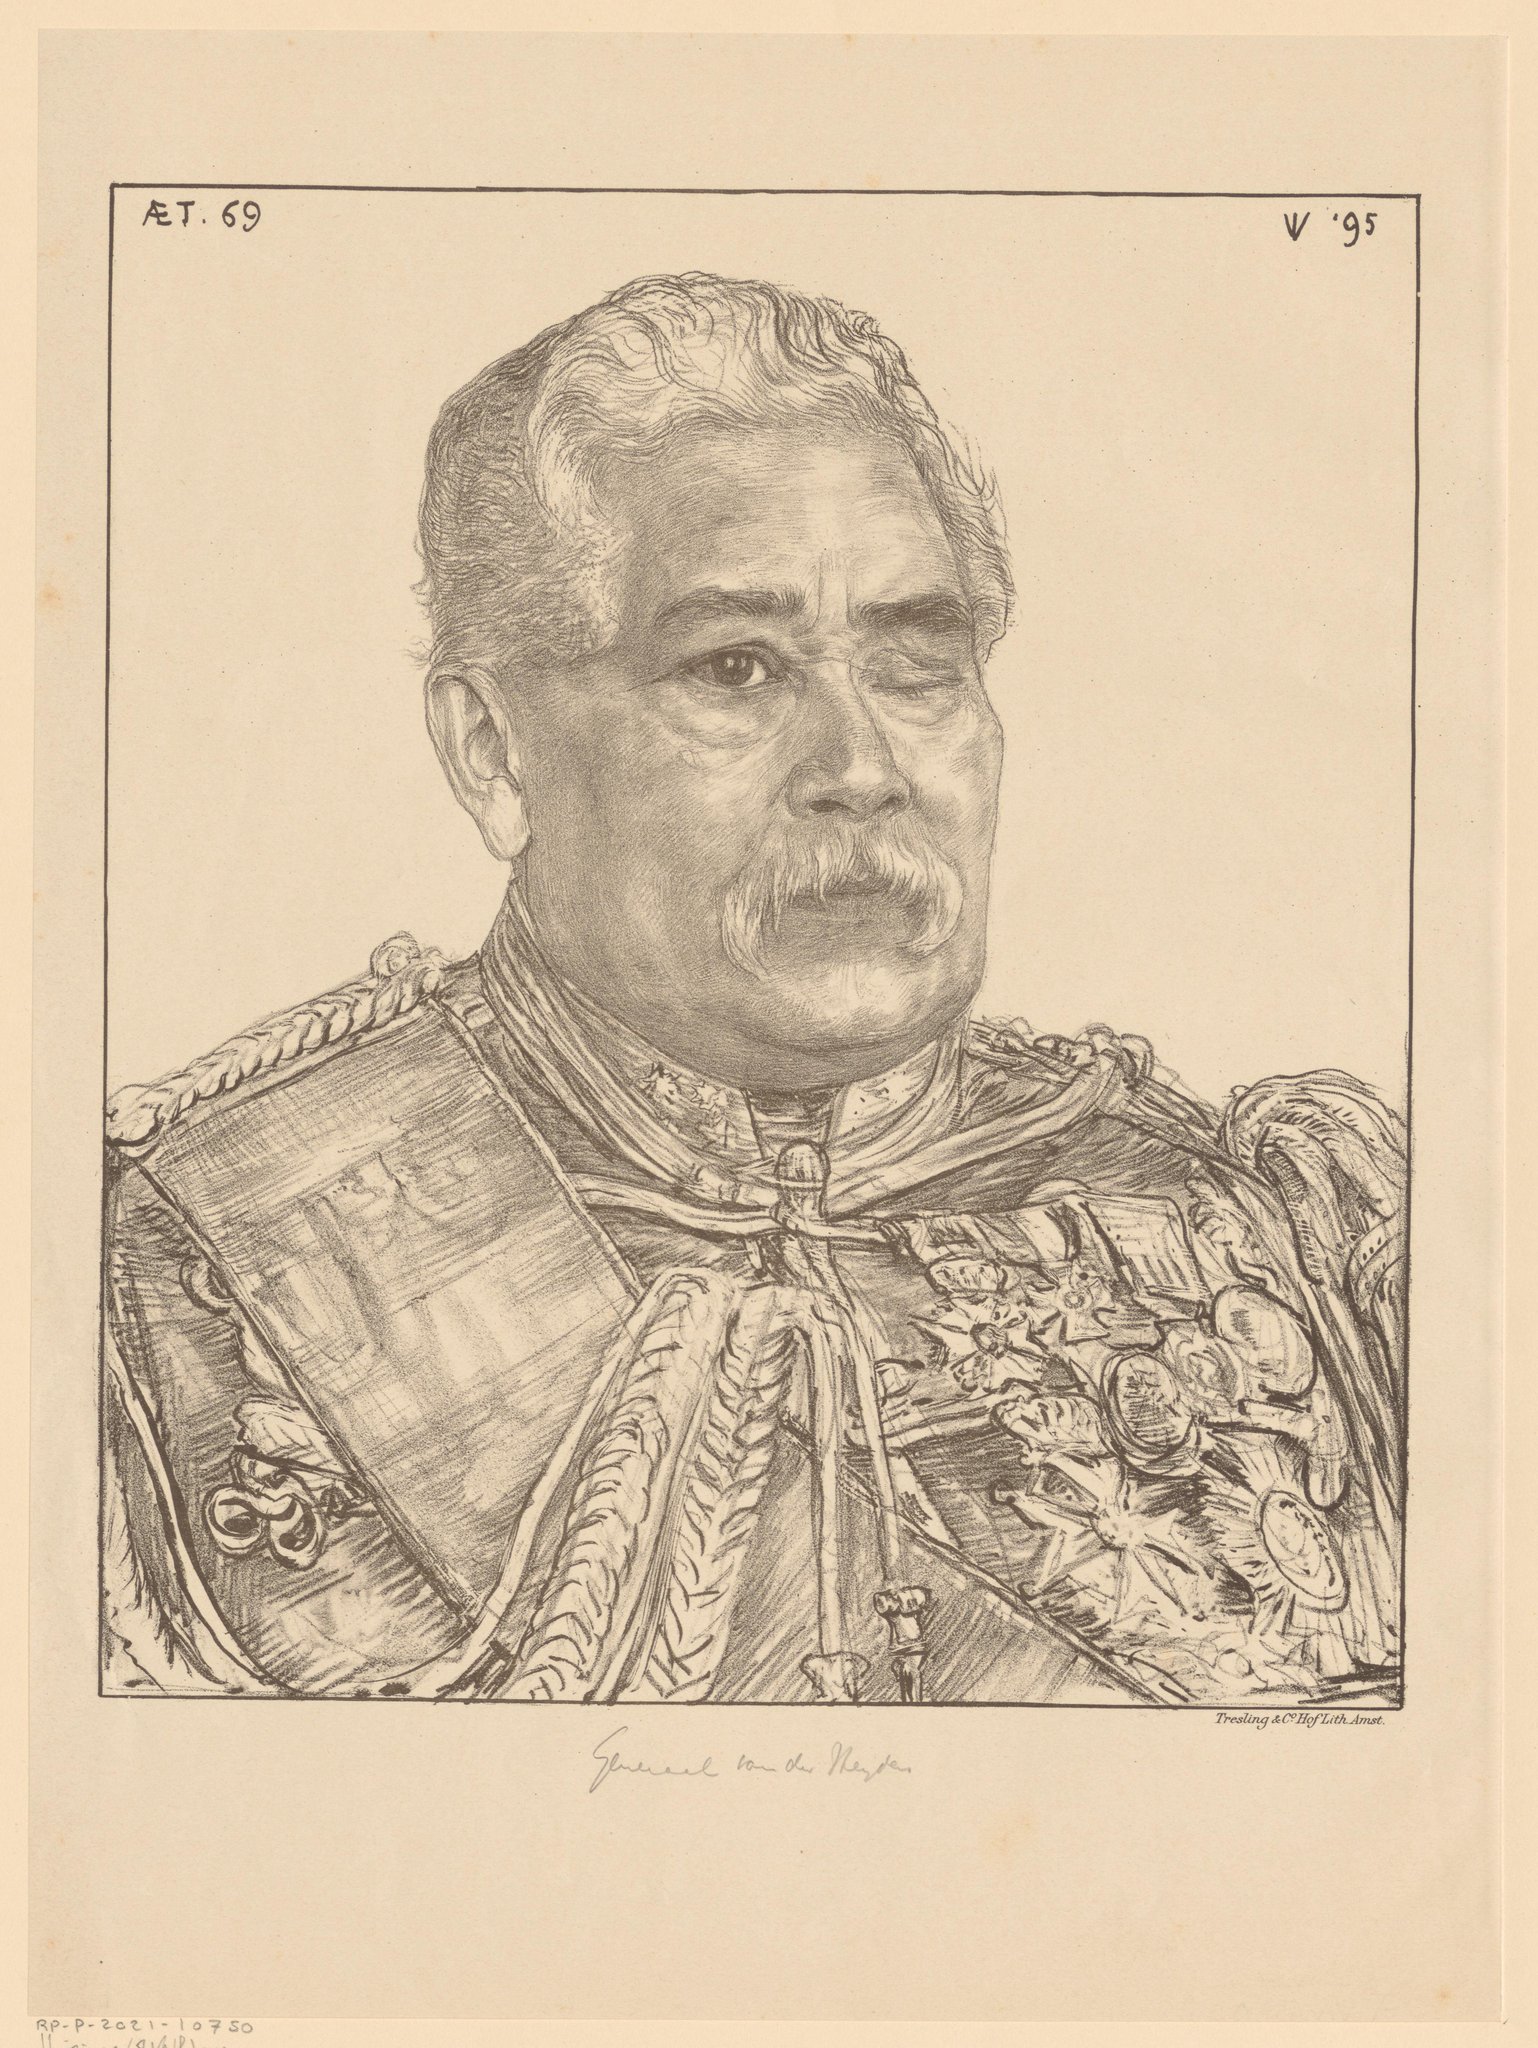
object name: print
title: Portret van Karel van der Heijden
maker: jan veth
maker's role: designer, draughtsman, painter, print maker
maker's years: 1864-1925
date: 1895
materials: paper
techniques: lithograph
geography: amsterdam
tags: commander-in-chief, general, marshal, historical persons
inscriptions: date